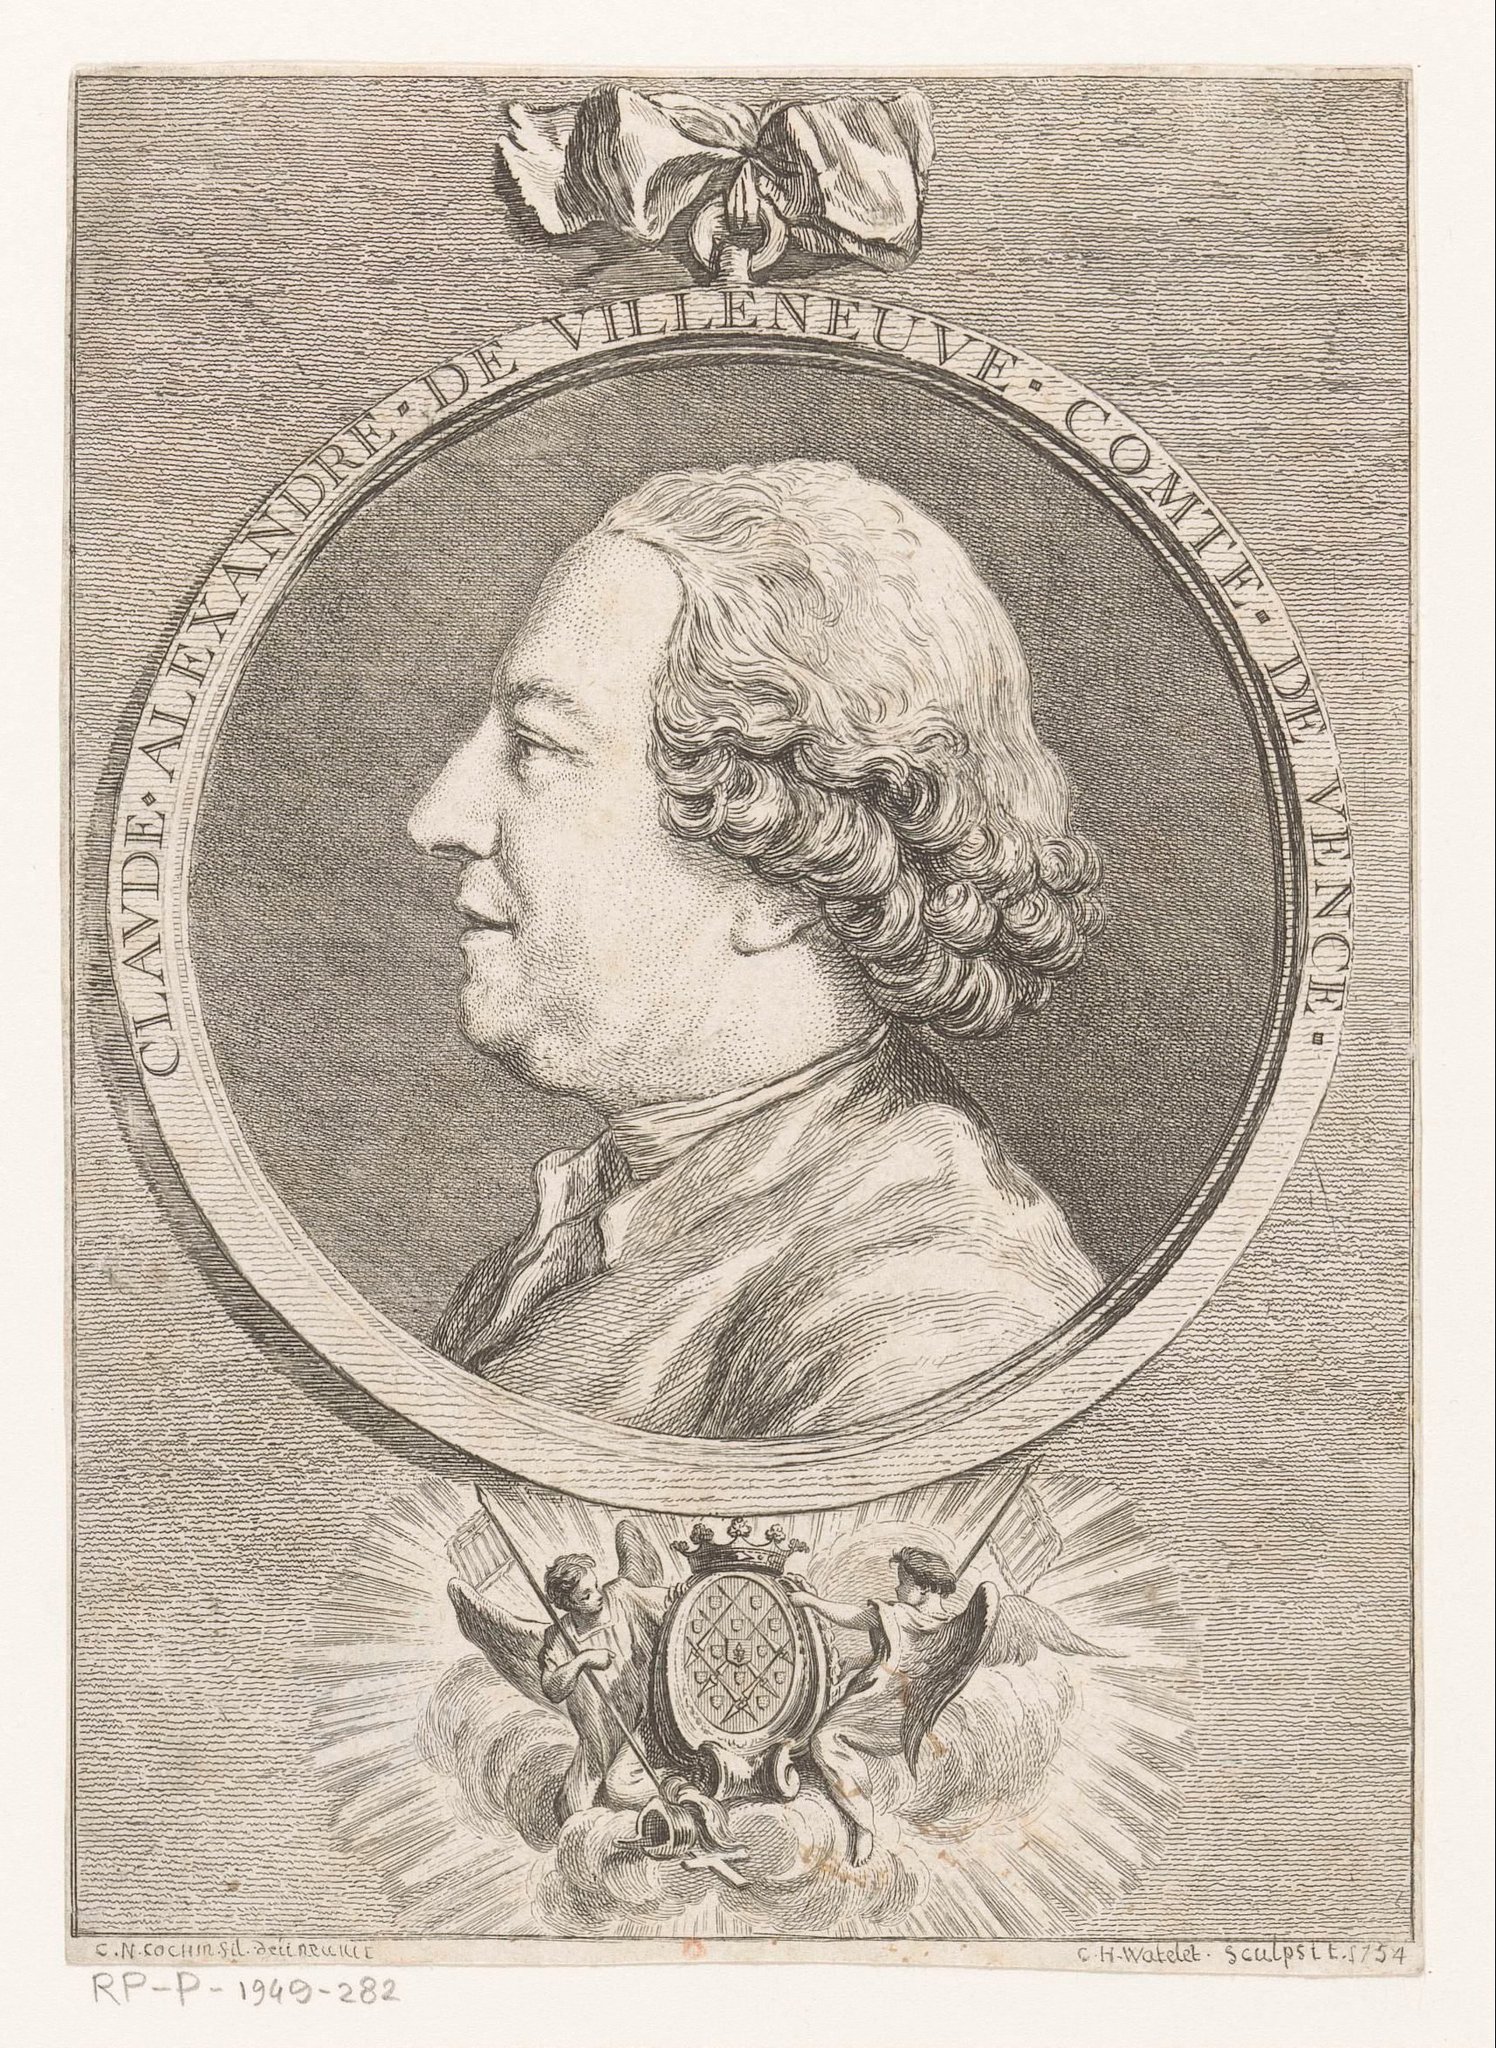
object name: print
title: Claude Alexandre de Villeneuve Comte de Vence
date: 1754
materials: paper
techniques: etching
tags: claude-alexander de villeneuve (comte de vence), historical persons, adult man (+ sideview, profile)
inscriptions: collector's mark: Lugt 2228, collector's mark: Lugt 4347